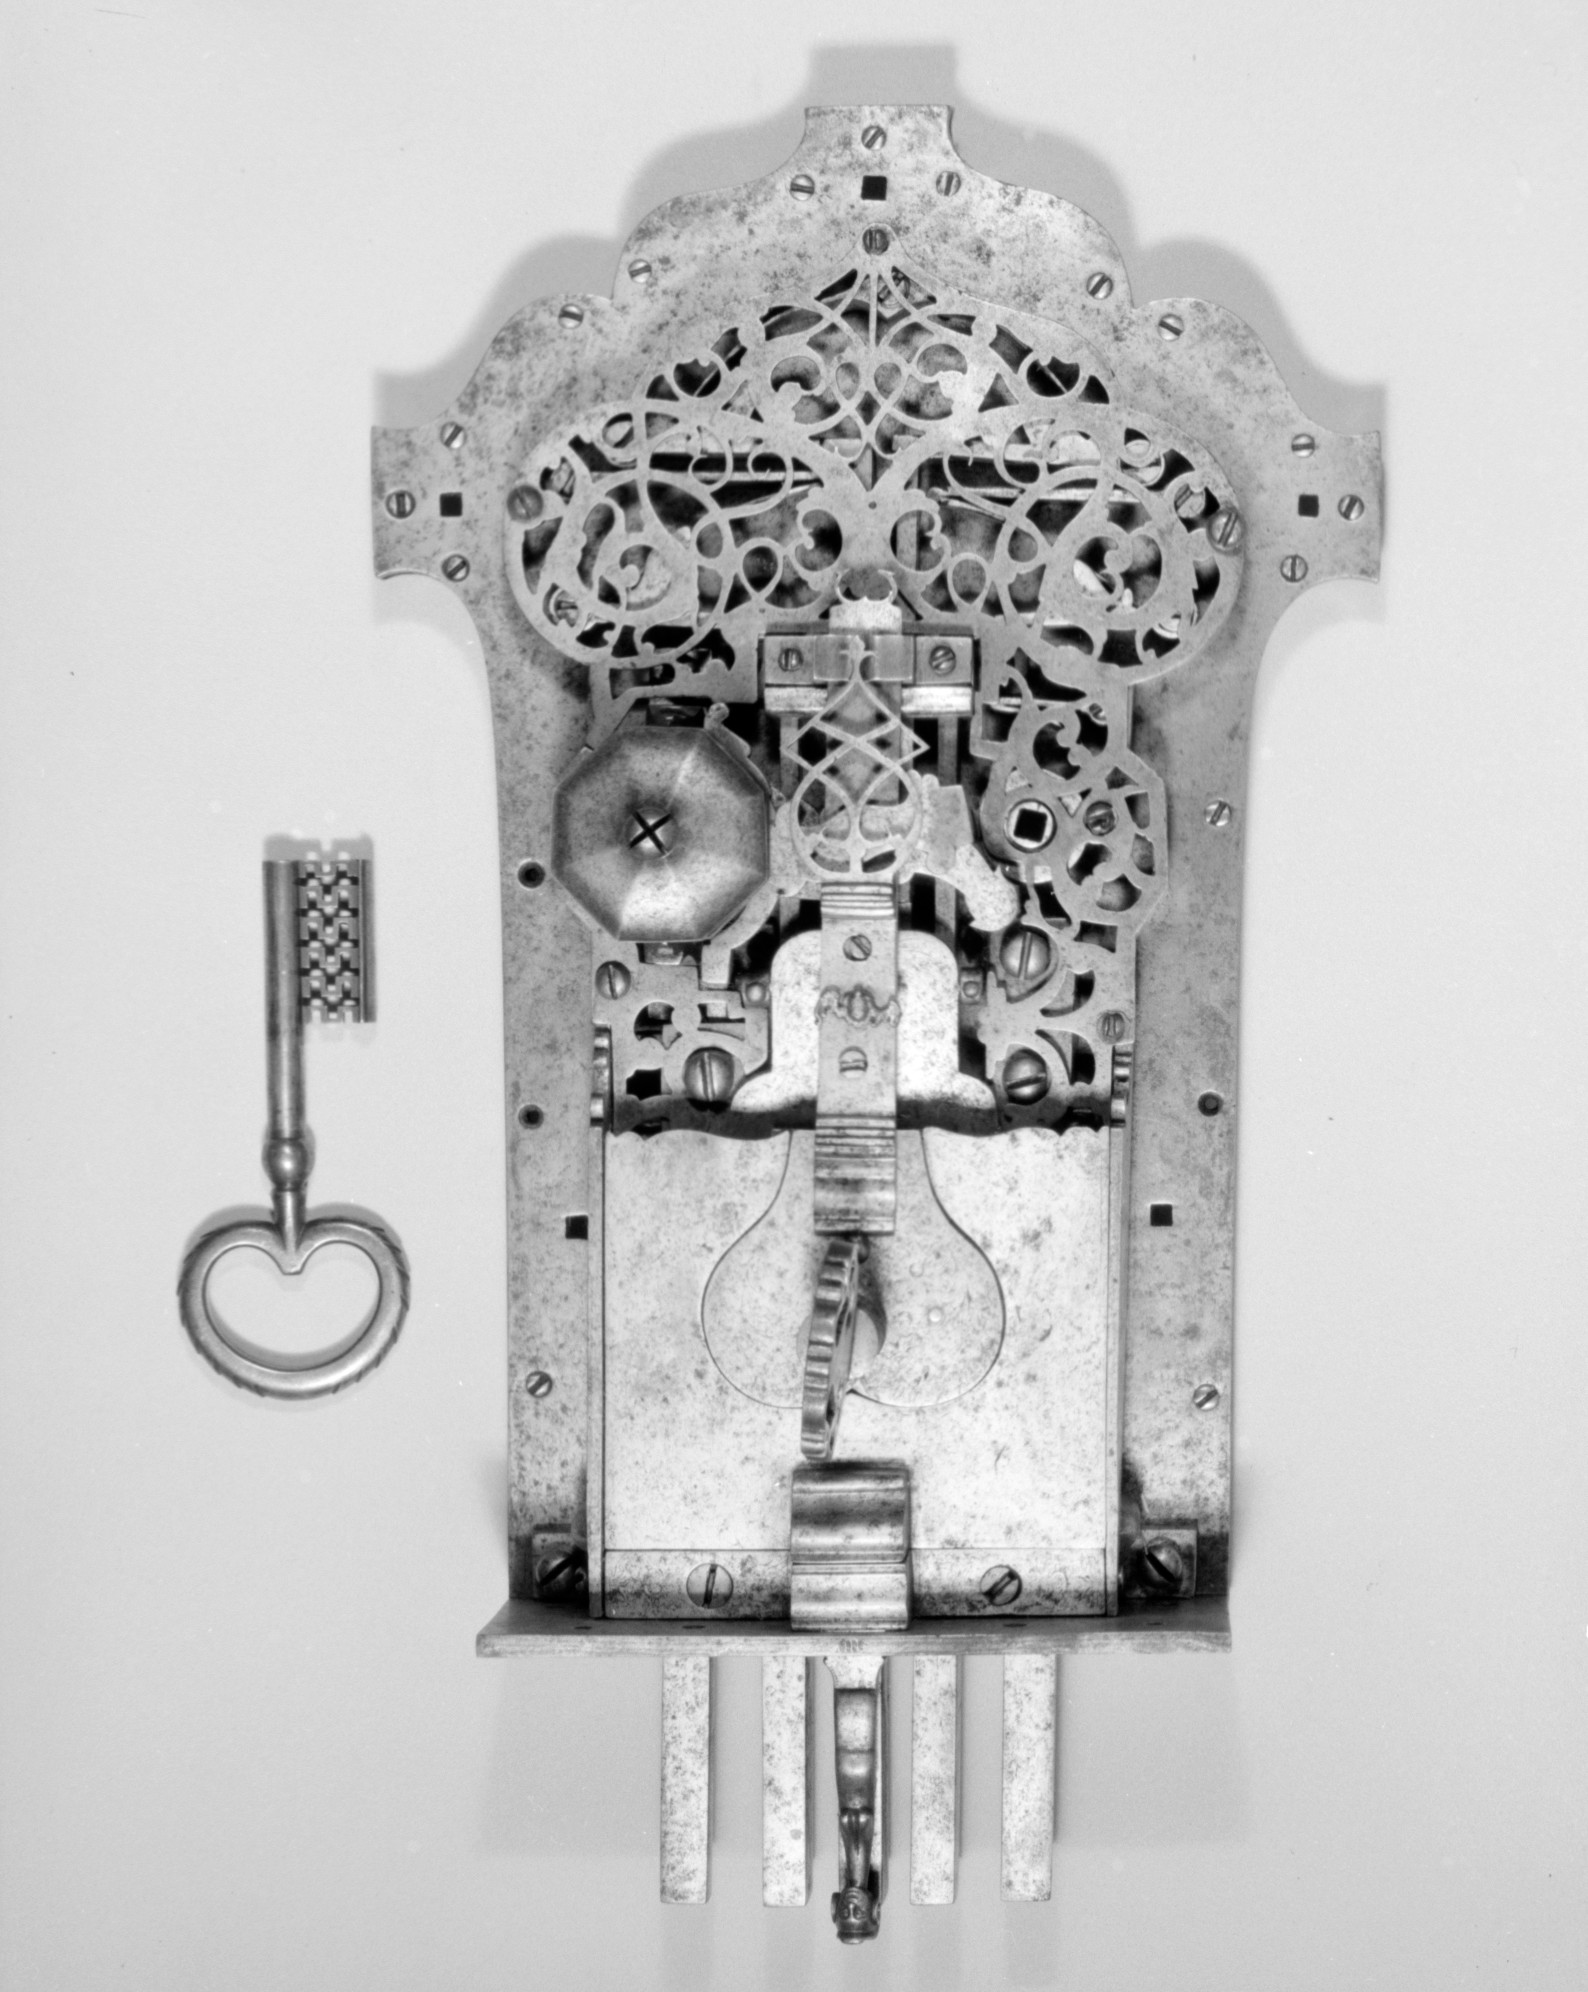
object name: lock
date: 1601-1700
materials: steel